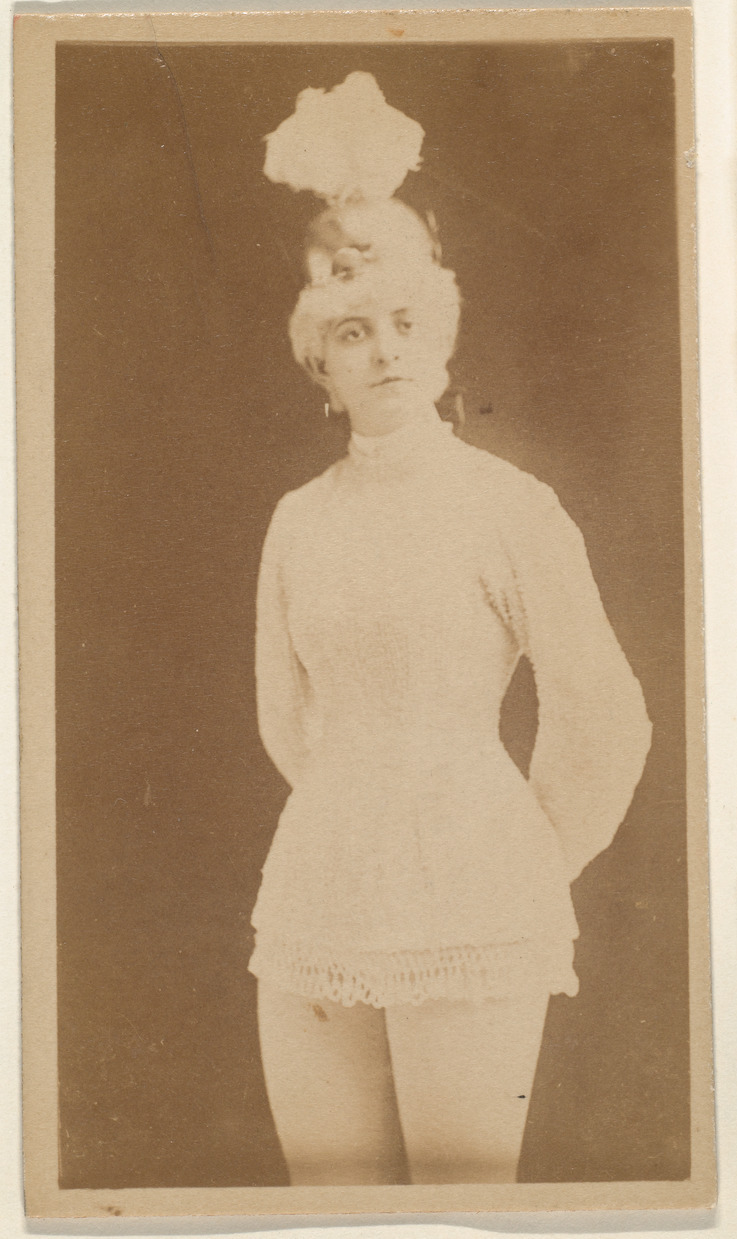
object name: photograph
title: Actress wearing plumed headpiece, from the Actresses series (N668)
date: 1888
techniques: albumen silver print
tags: portraits,women,actresses